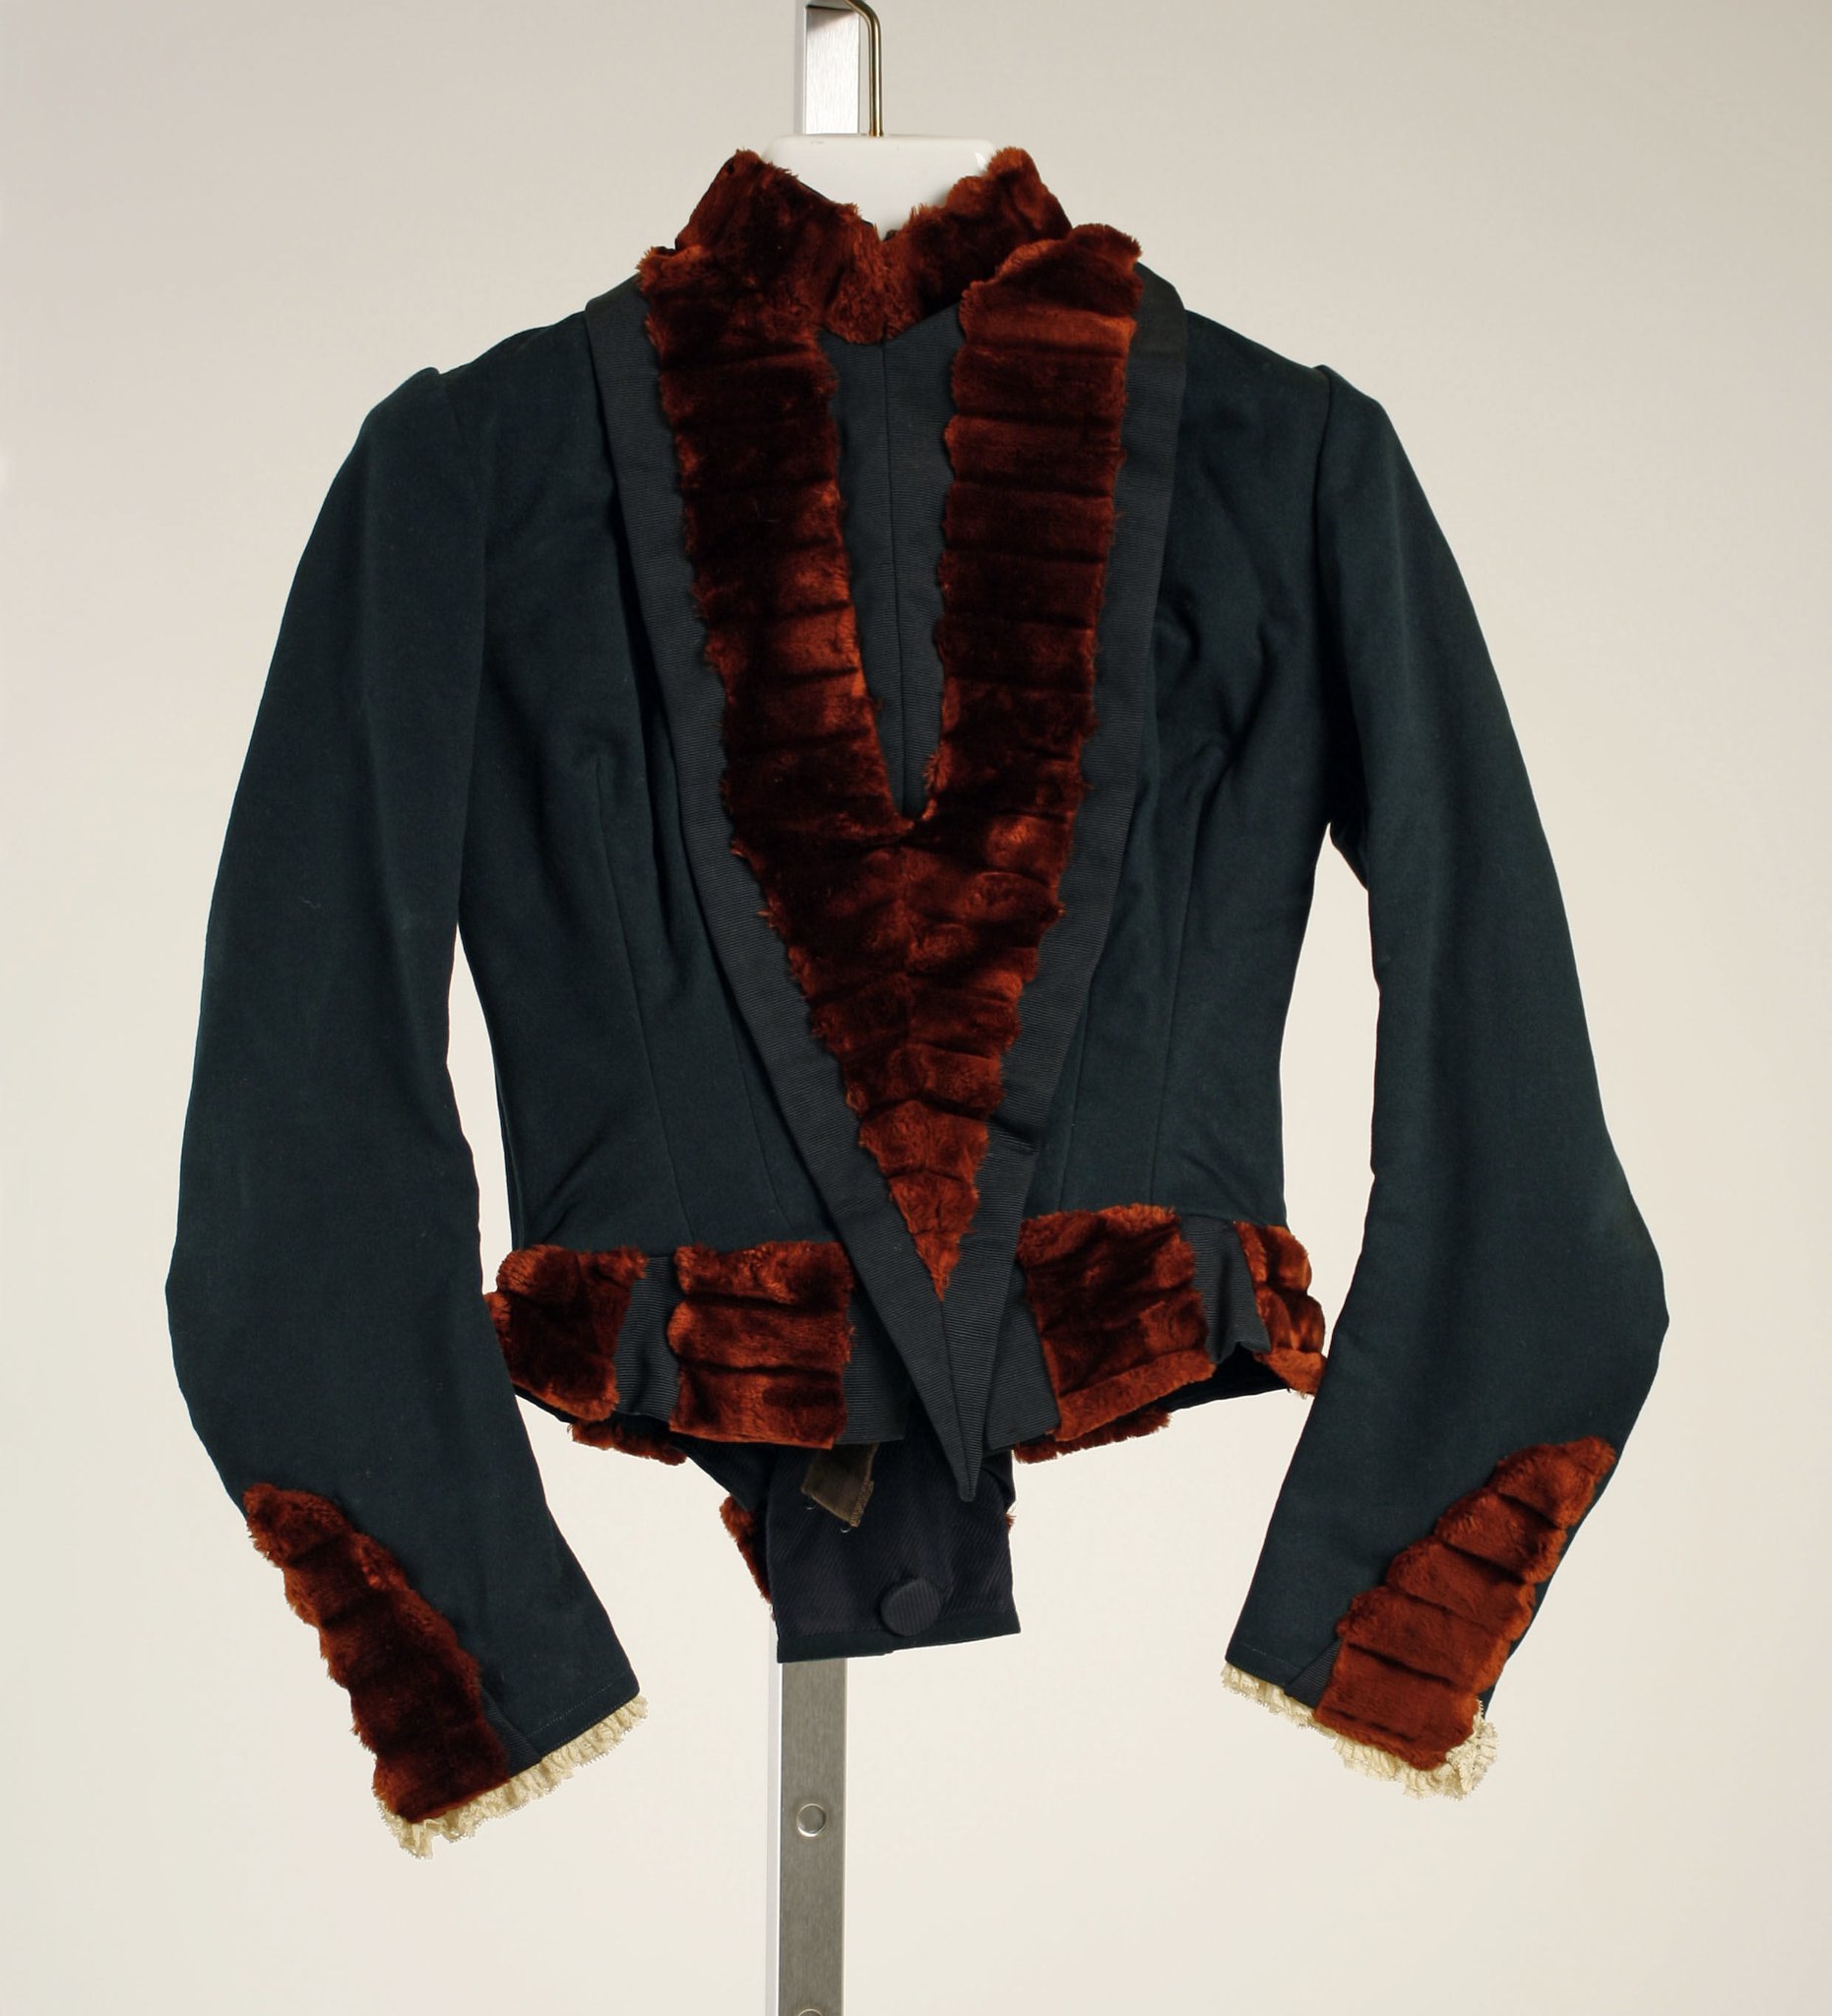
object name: walking dress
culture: american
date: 1885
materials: wool